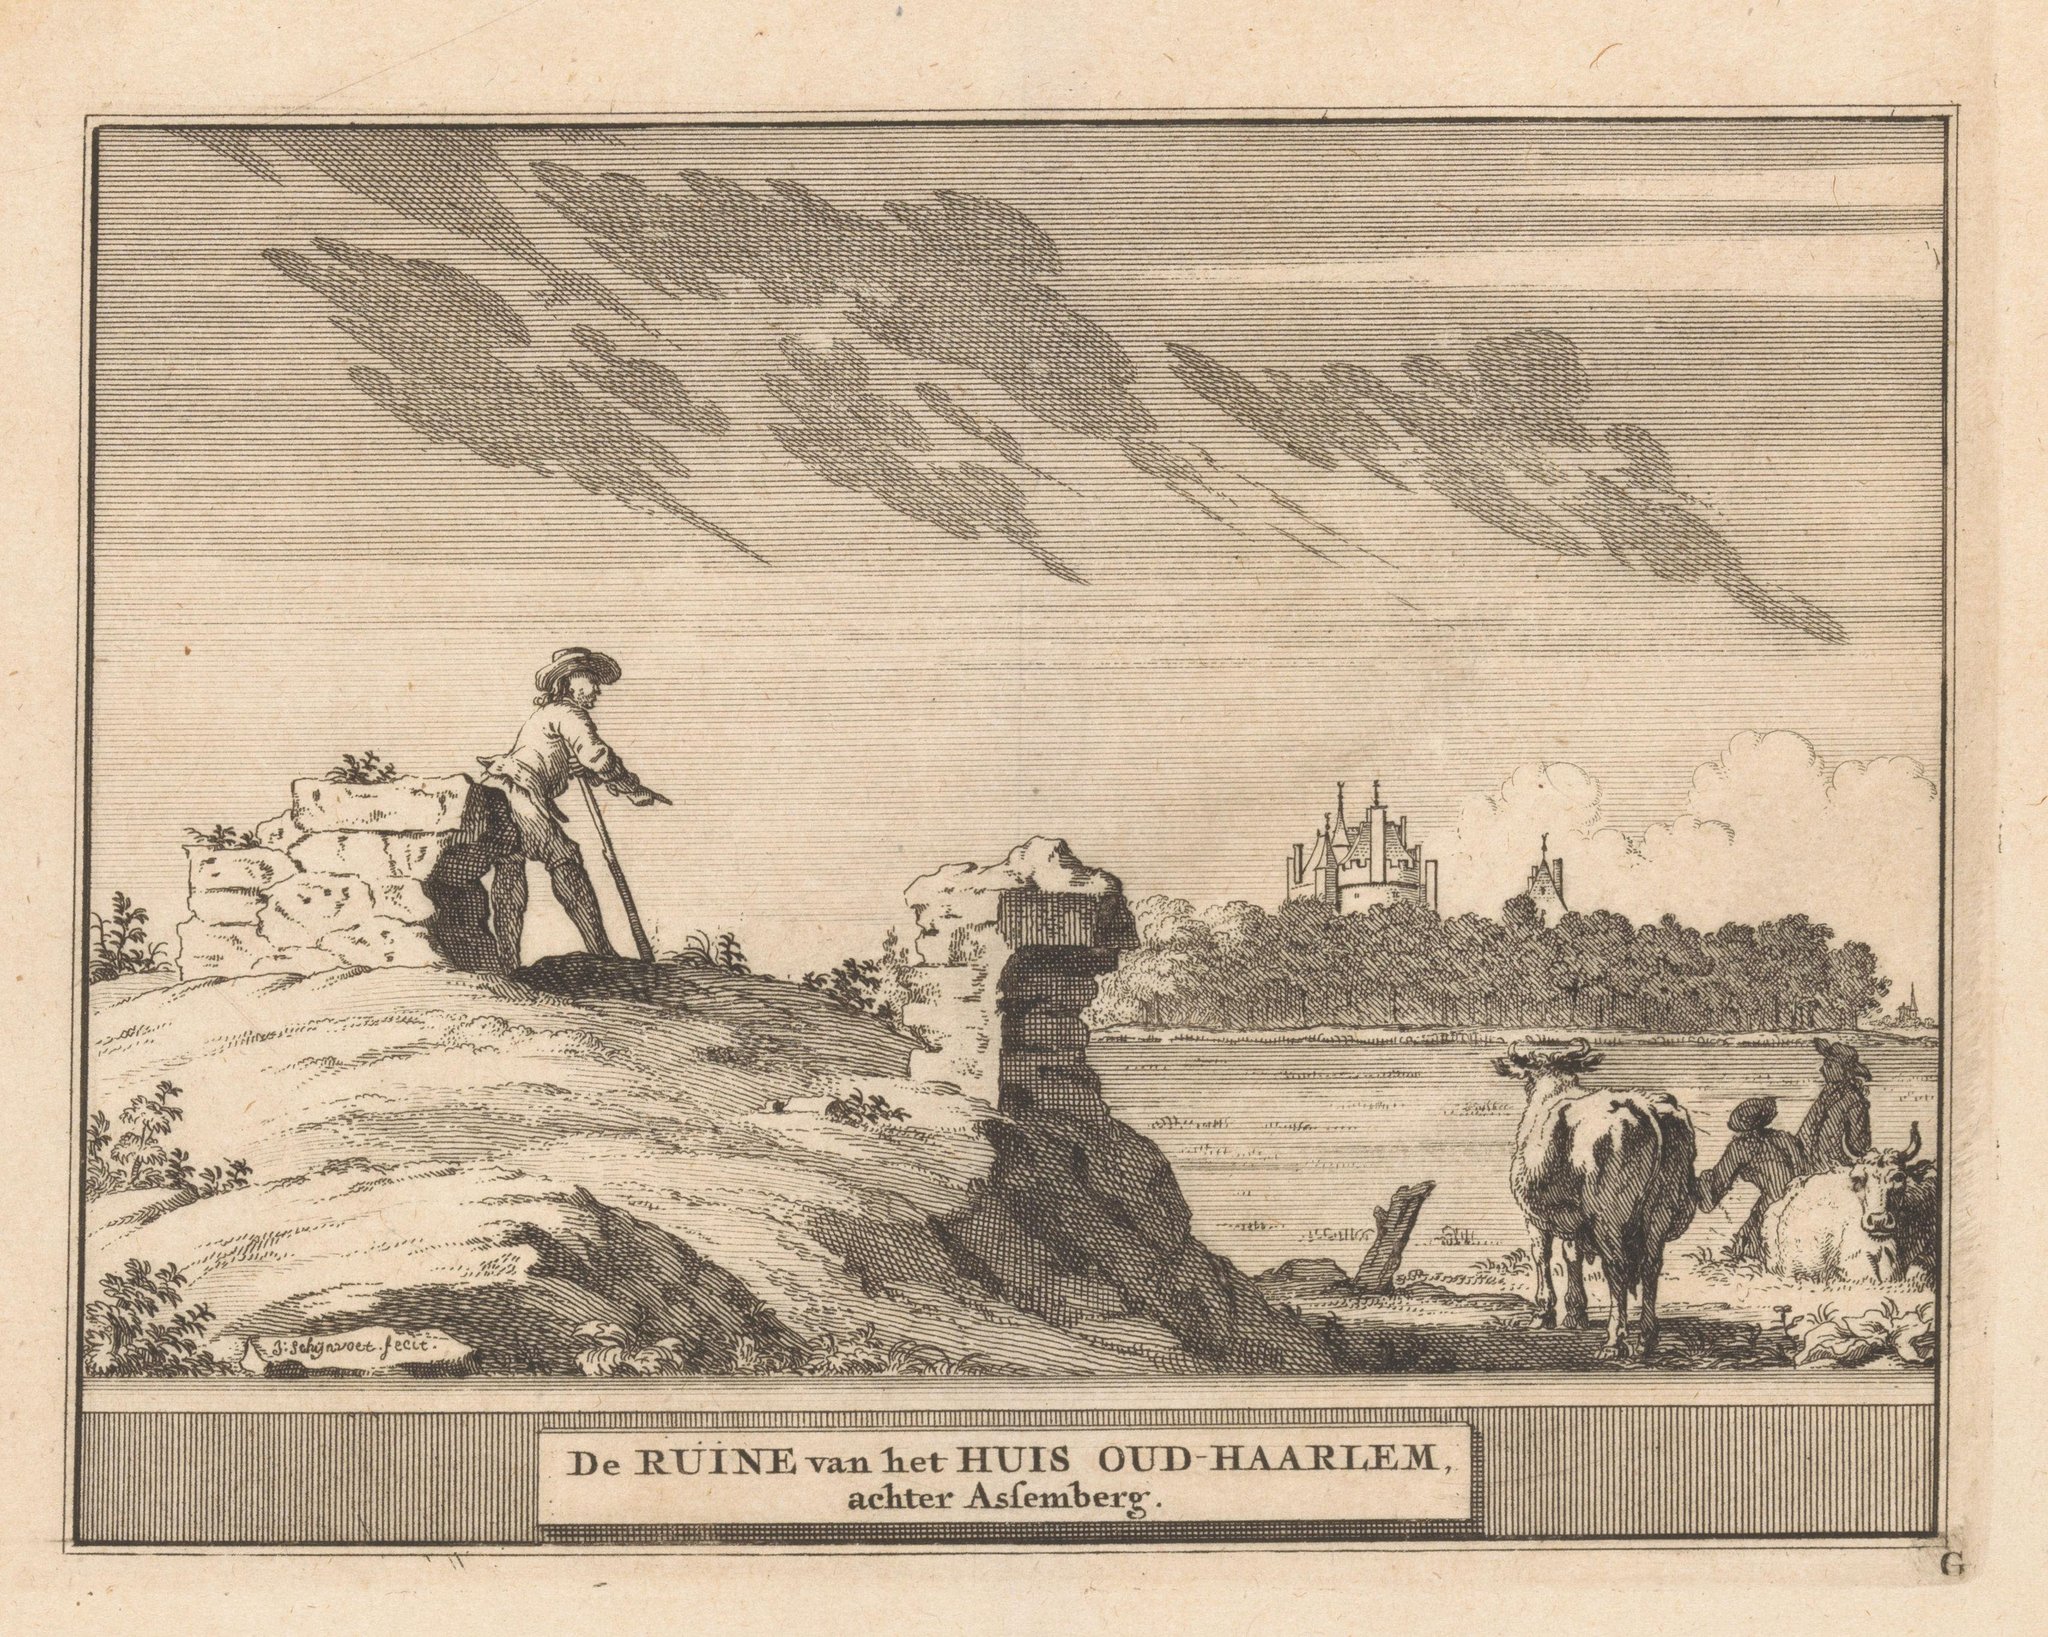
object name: book illustration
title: De ruïne van het huis Oud-Haarlem, achter Assemberg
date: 1711-1774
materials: paper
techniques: engraving, etching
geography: amsterdam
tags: cow, castle, ruin of a dwelling, house, castle, etc.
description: Prent ook gebruikt in: Smids, Ludolf. Schatkamer der Nederlandsse oudheden; of woordenboek, behelsende Nederlands steden en dorpen, kasteelen, sloten en heeren huysen (…). Amsterdam: Pieter de Coup, 1711, tussen p. 126 en 127. Het is ook mogelijk dat deze prent uit de tweede (1737) of derde (1774) druk komt, of uit een uitgave met alleen de prenten: Nederlandsche oudheden, bestaande in zestig verbeeldingen (...) gelegen in Holland, 't Sticht van Utrecht en Gelderland enz. Amsterdam: Hendrik Bosch, 1721.